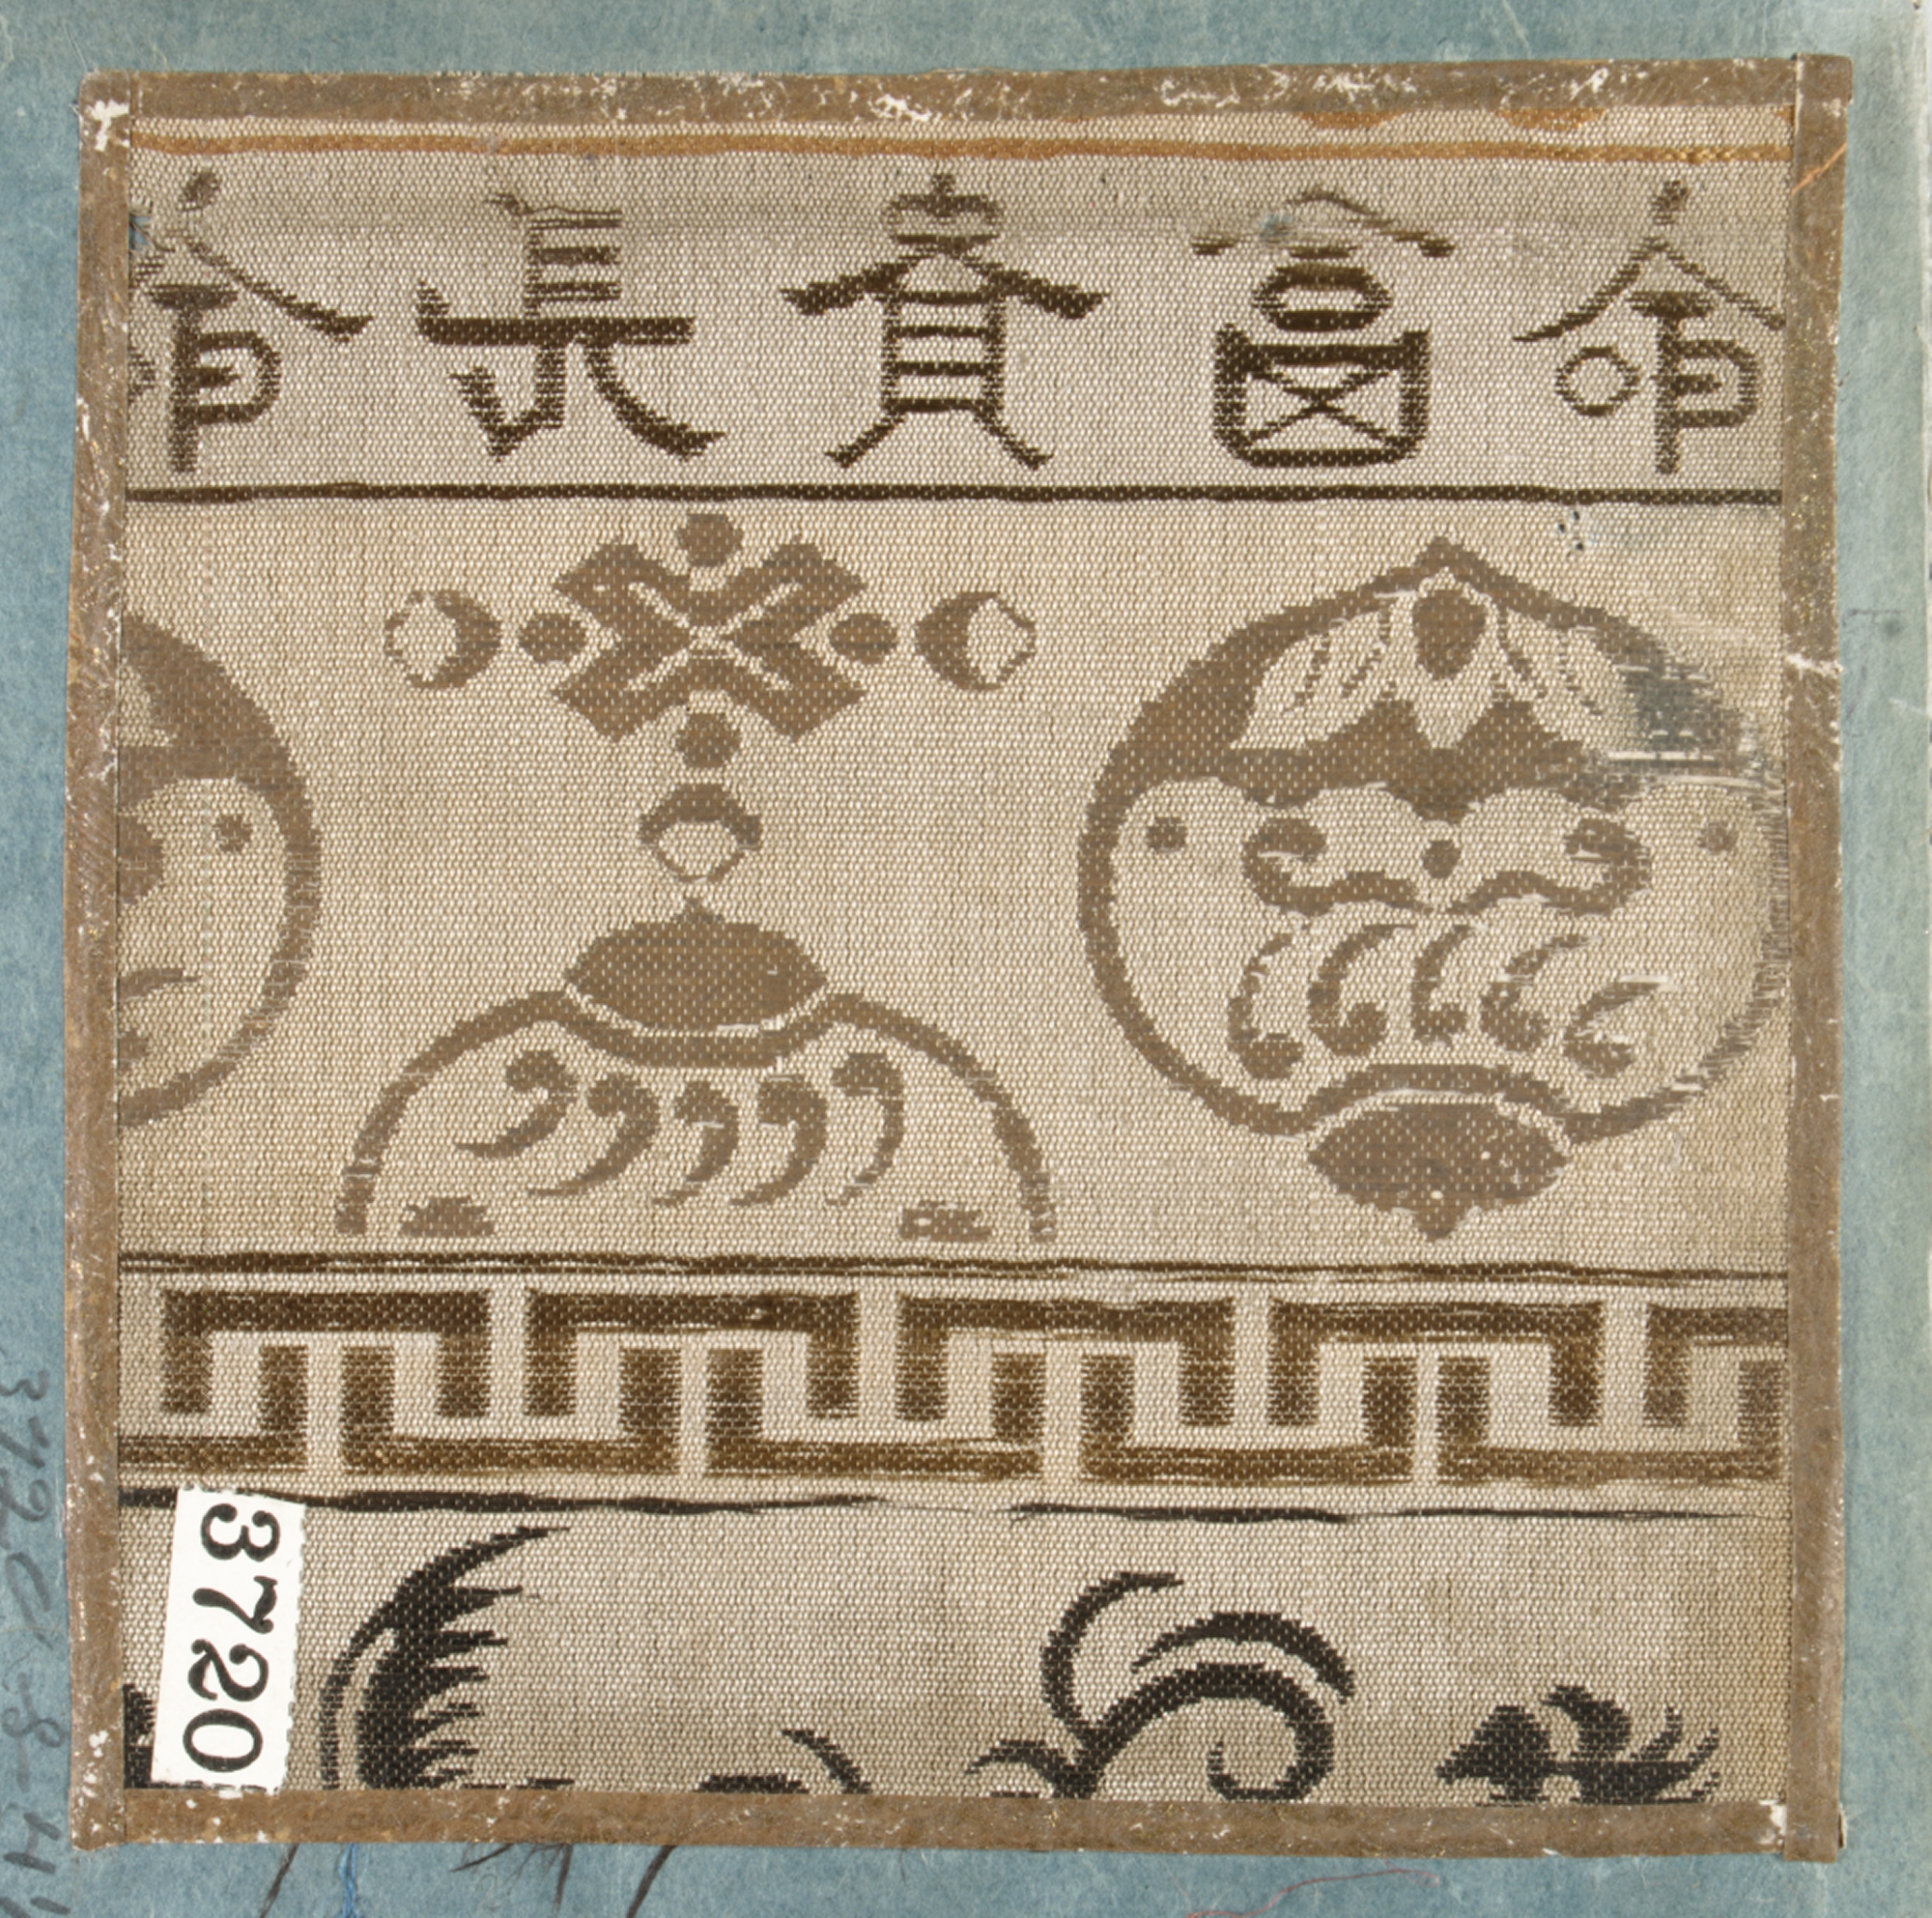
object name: sample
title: Textile Sample from Sample Book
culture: japanese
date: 1801-1900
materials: silk